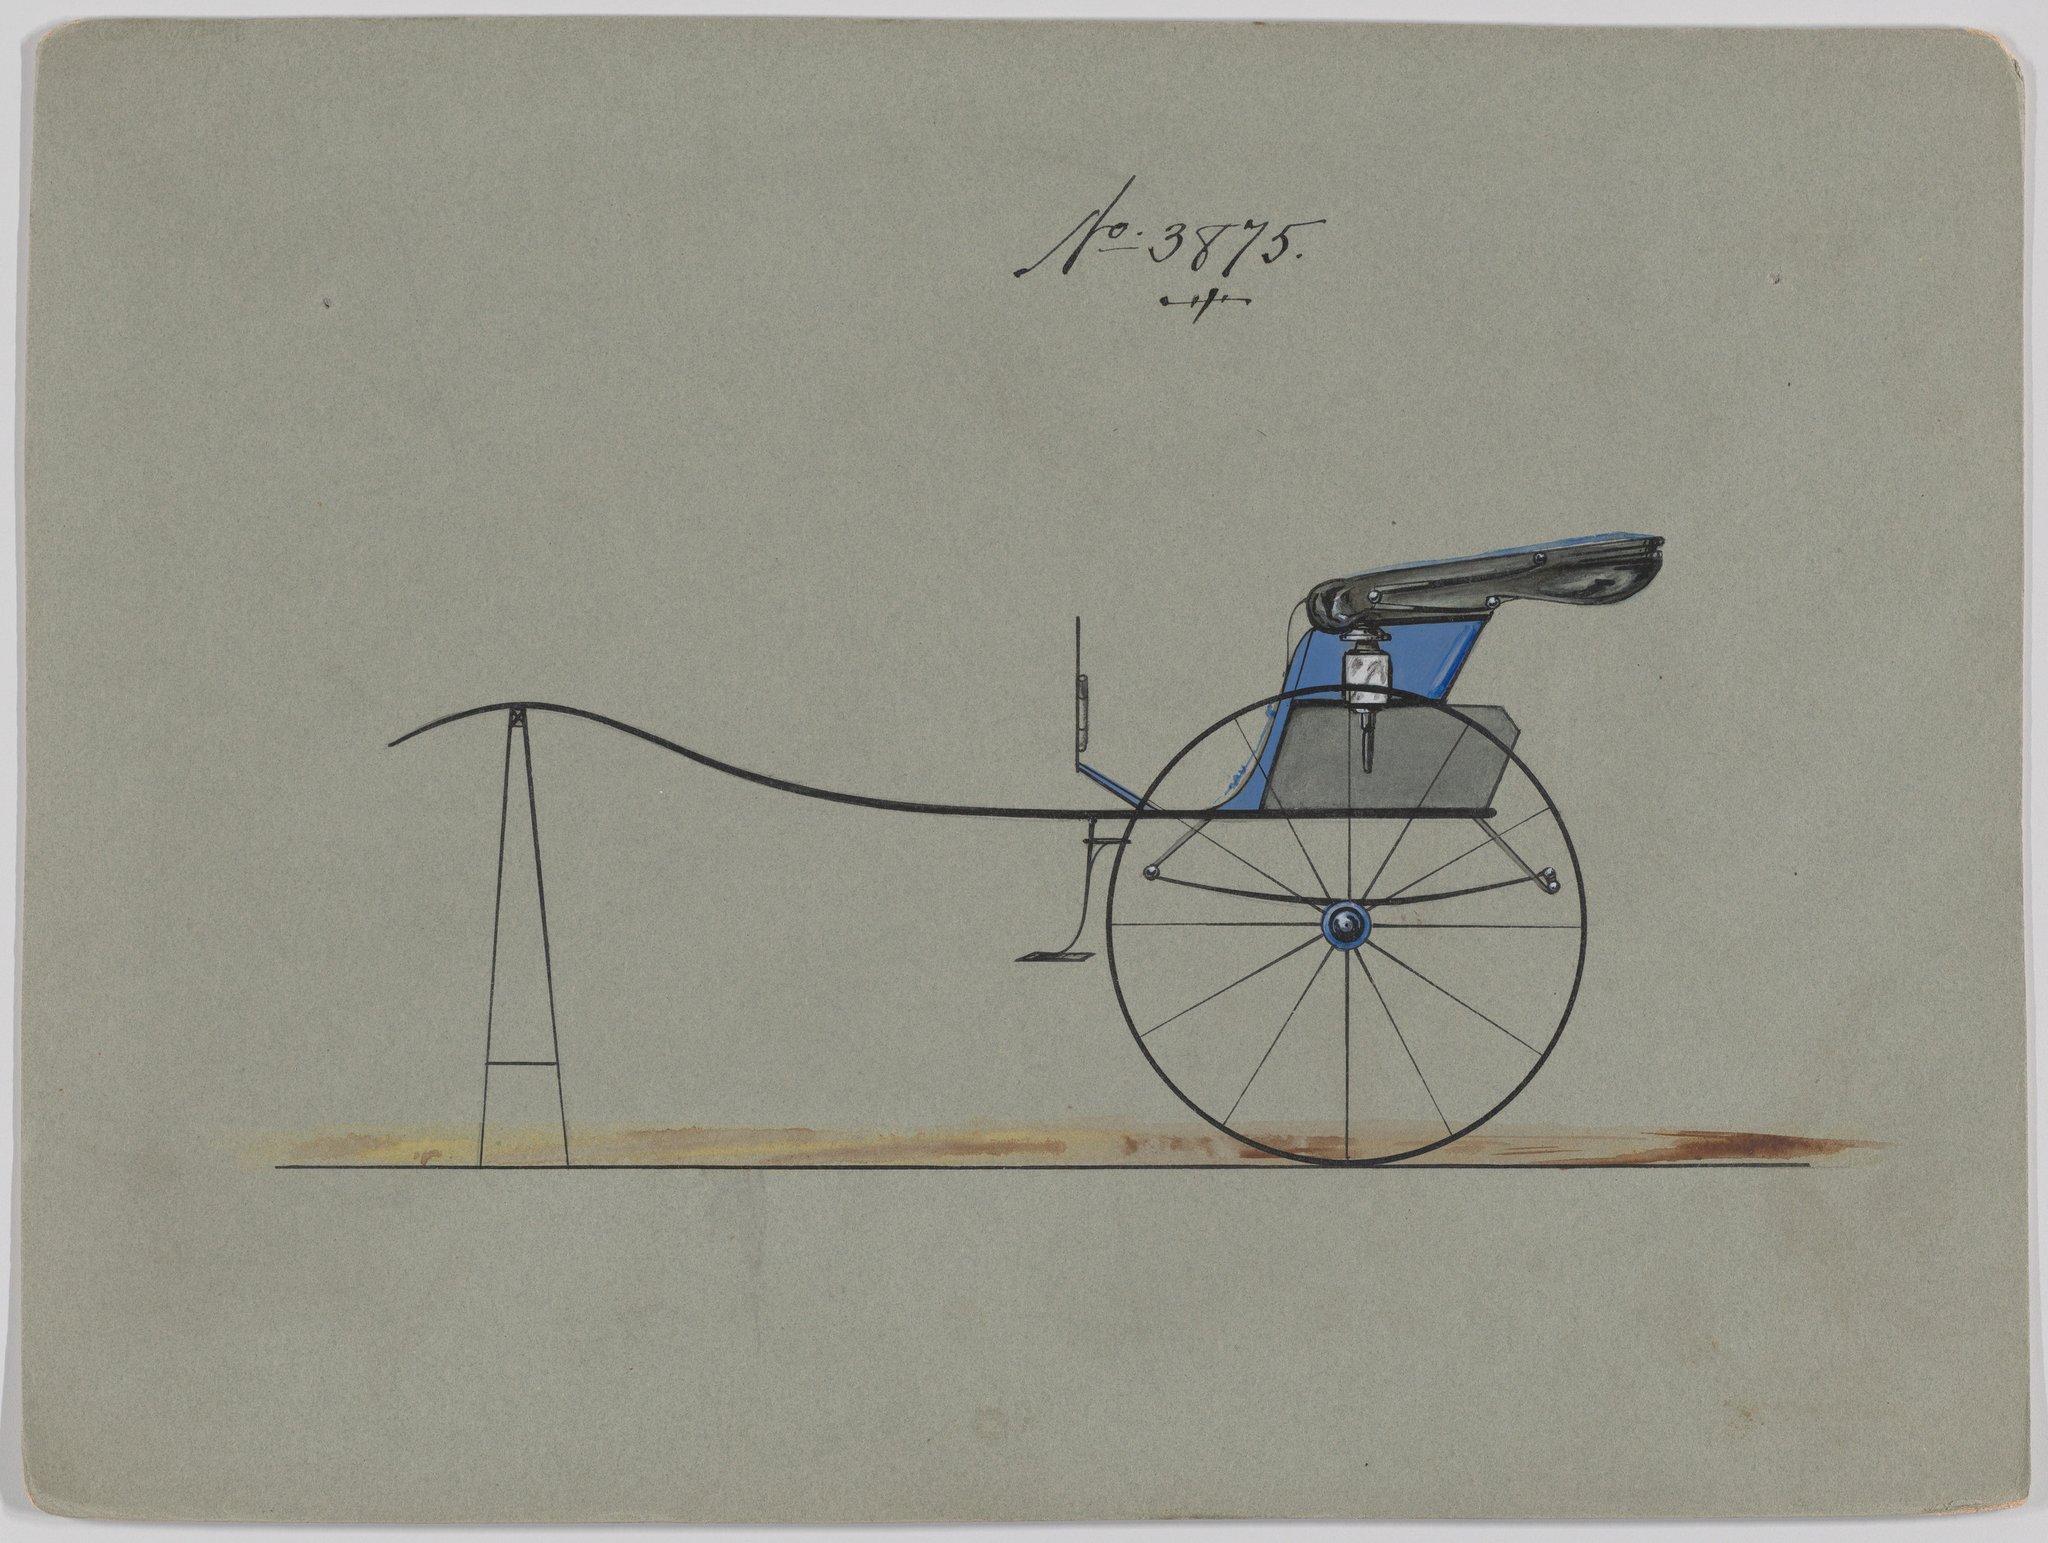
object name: drawing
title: Design for Dog Cart or 2 Wheeler, no. 3875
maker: brewster & co.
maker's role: manufacturer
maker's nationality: american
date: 1884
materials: gouache, gum arabic, ink, watercolor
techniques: pen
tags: carriages